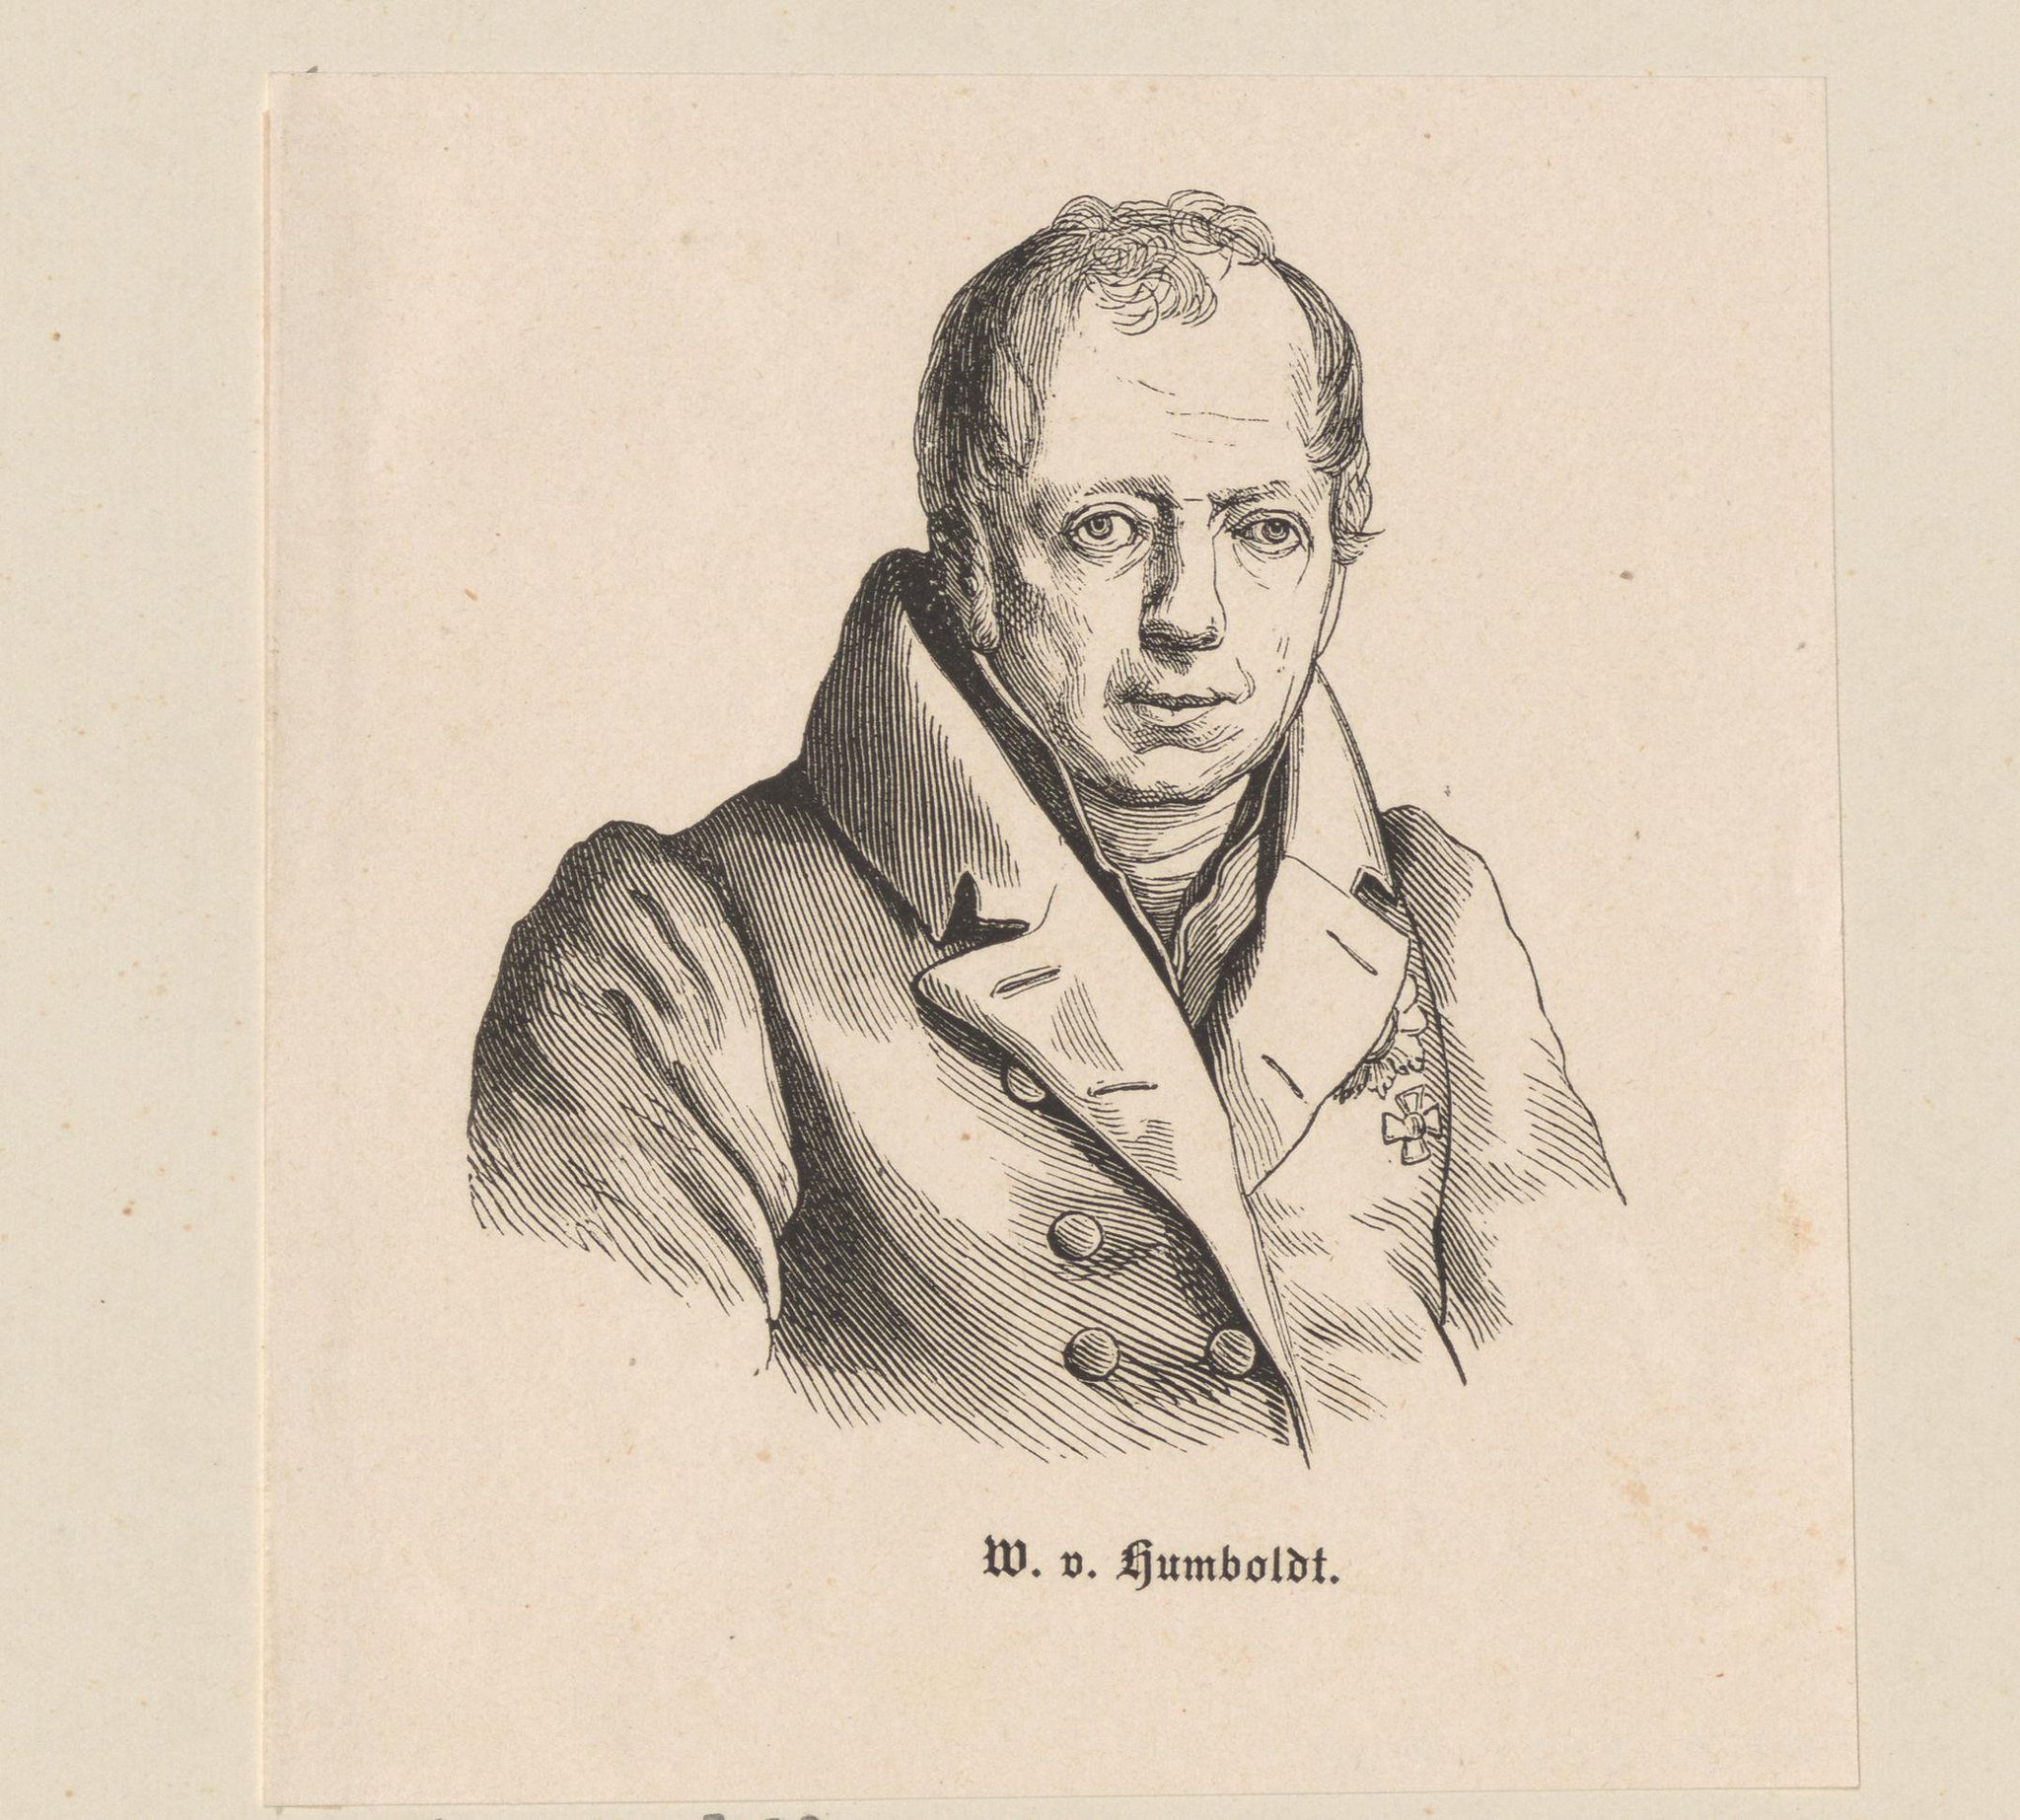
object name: print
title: Portret van Wilhelm von Humboldt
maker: Anonymous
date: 1800-1849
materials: paper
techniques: letterpress printing, engraving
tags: scholar, philosopher, historical persons